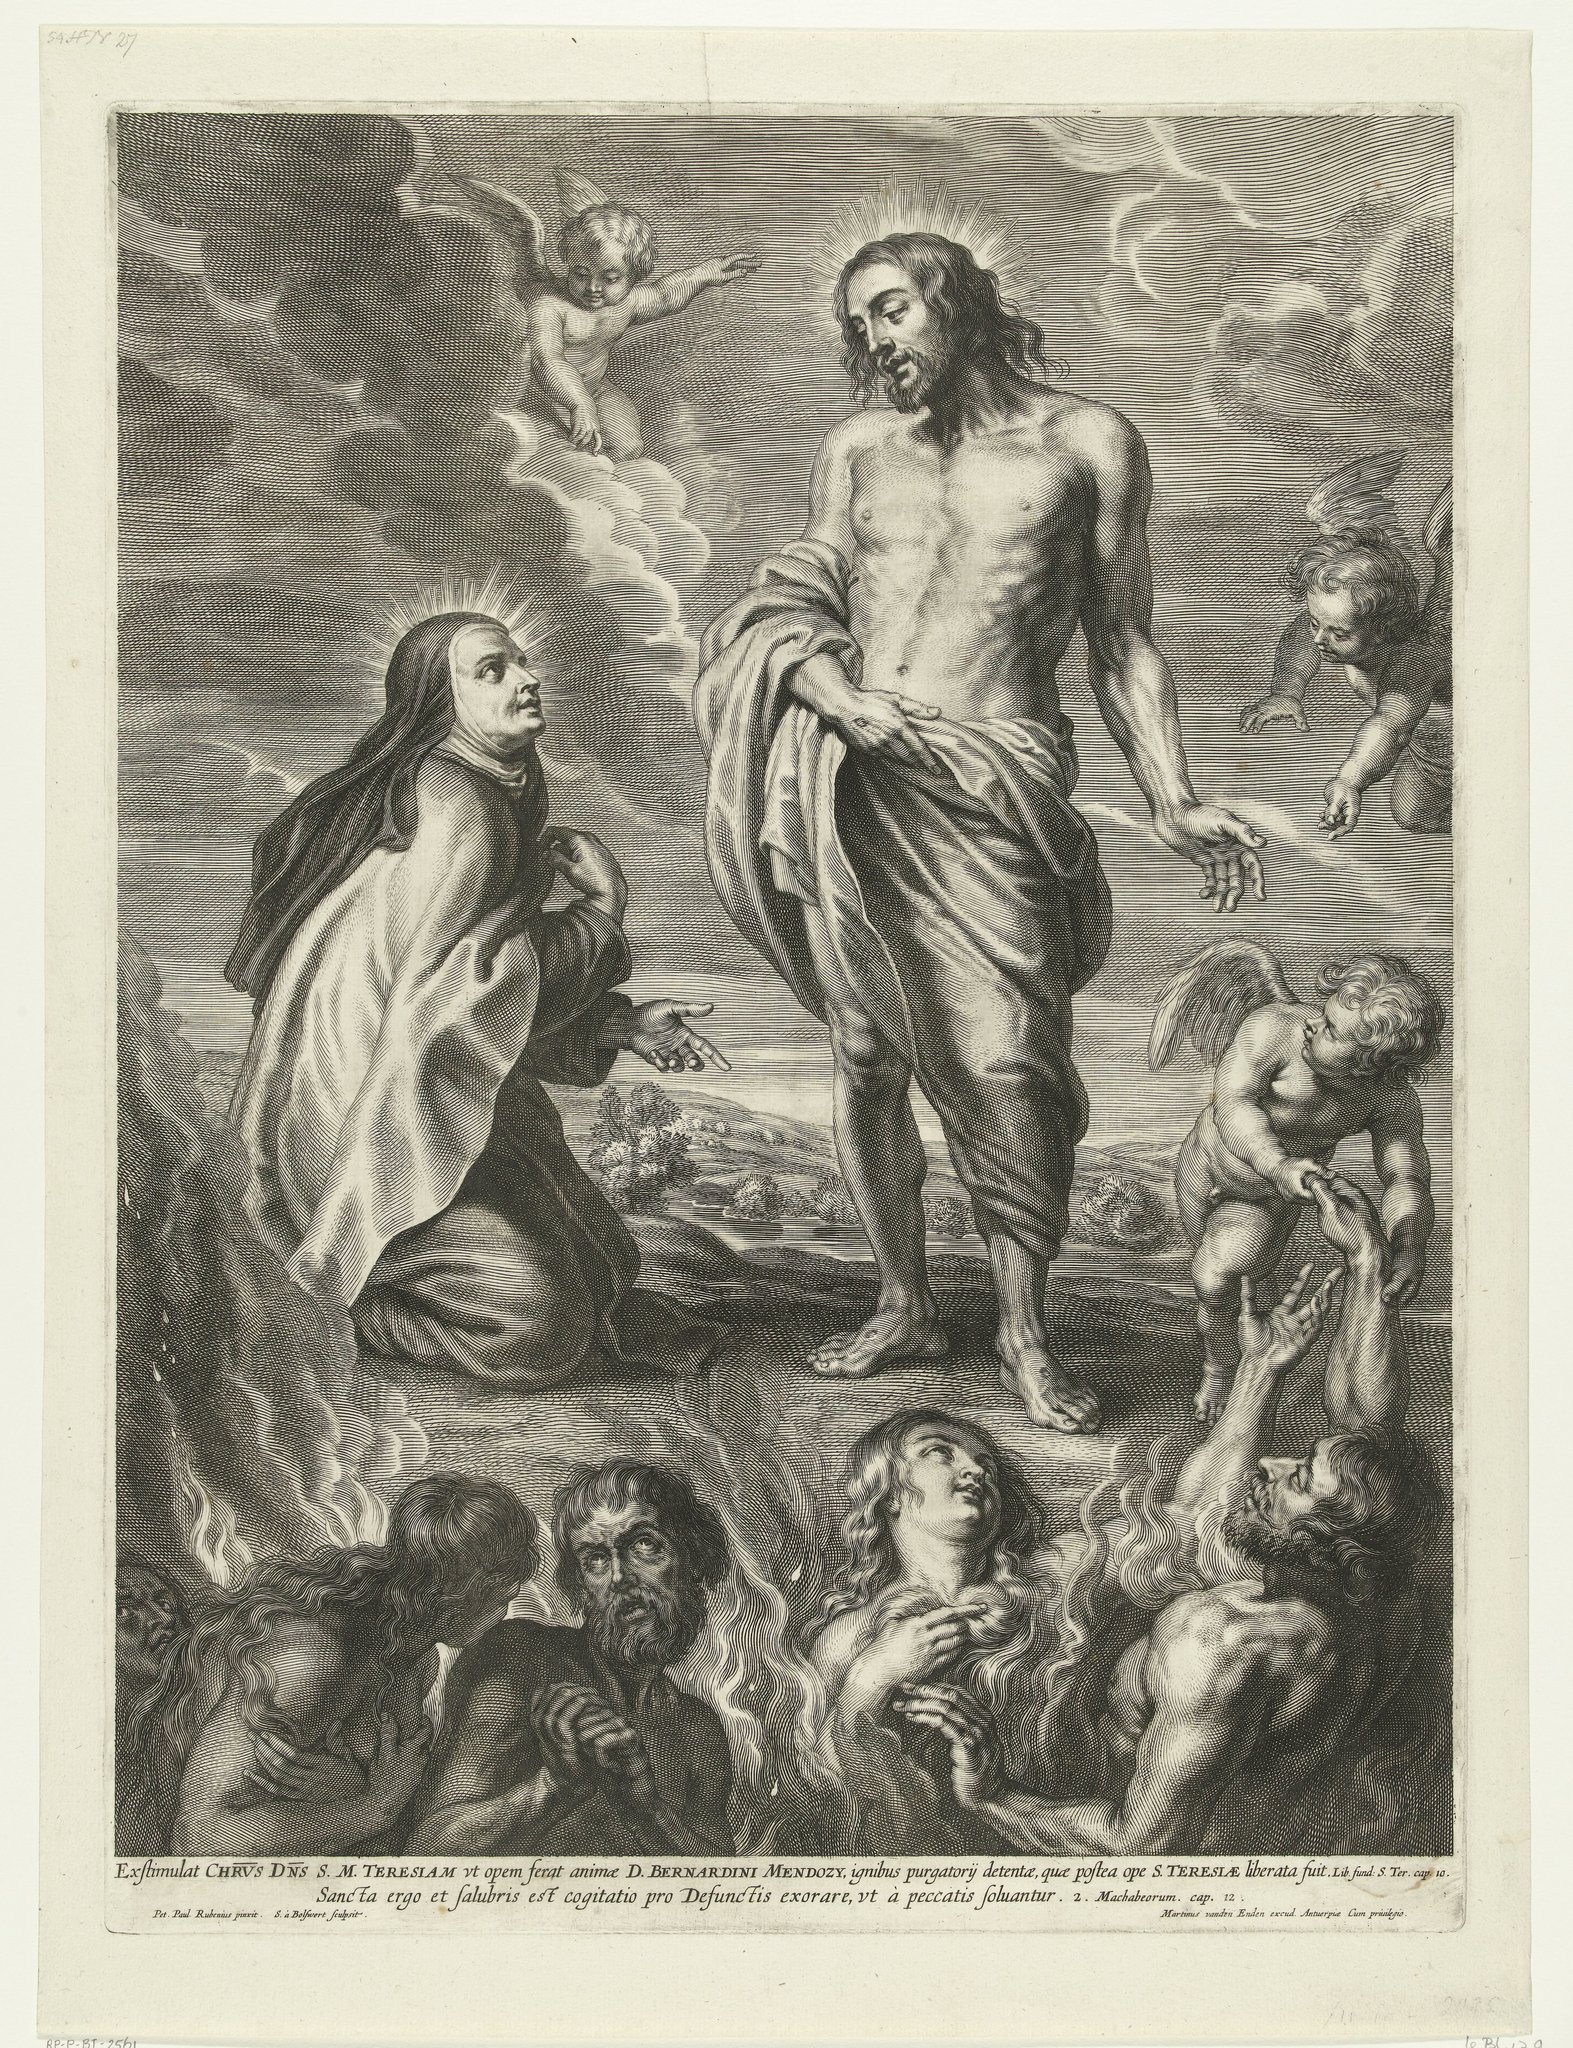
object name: print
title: Heilige Teresa voor Christus als voorspraak voor zielen in het vagevuur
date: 1596-1659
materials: paper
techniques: engraving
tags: purgatory, usually the souls praying or asking for intercession, st. theresa kneeling before christ, interceding for the souls in purgatory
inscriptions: collector's mark: Lugt 240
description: Heilige Teresa knielt voor Christus als voorspraak voor zielen in het vagevuur. Zij wijst naar de mannen en vrouwen in het vuur die onder hen smekend naar boven kijken. Volgens het onderschrift handelt Teresa op voorspraak van de ziel van Bernardino de Mendoza. Ook wordt een bijbeltekst geciteerd: 2 Makkabeeën 12.